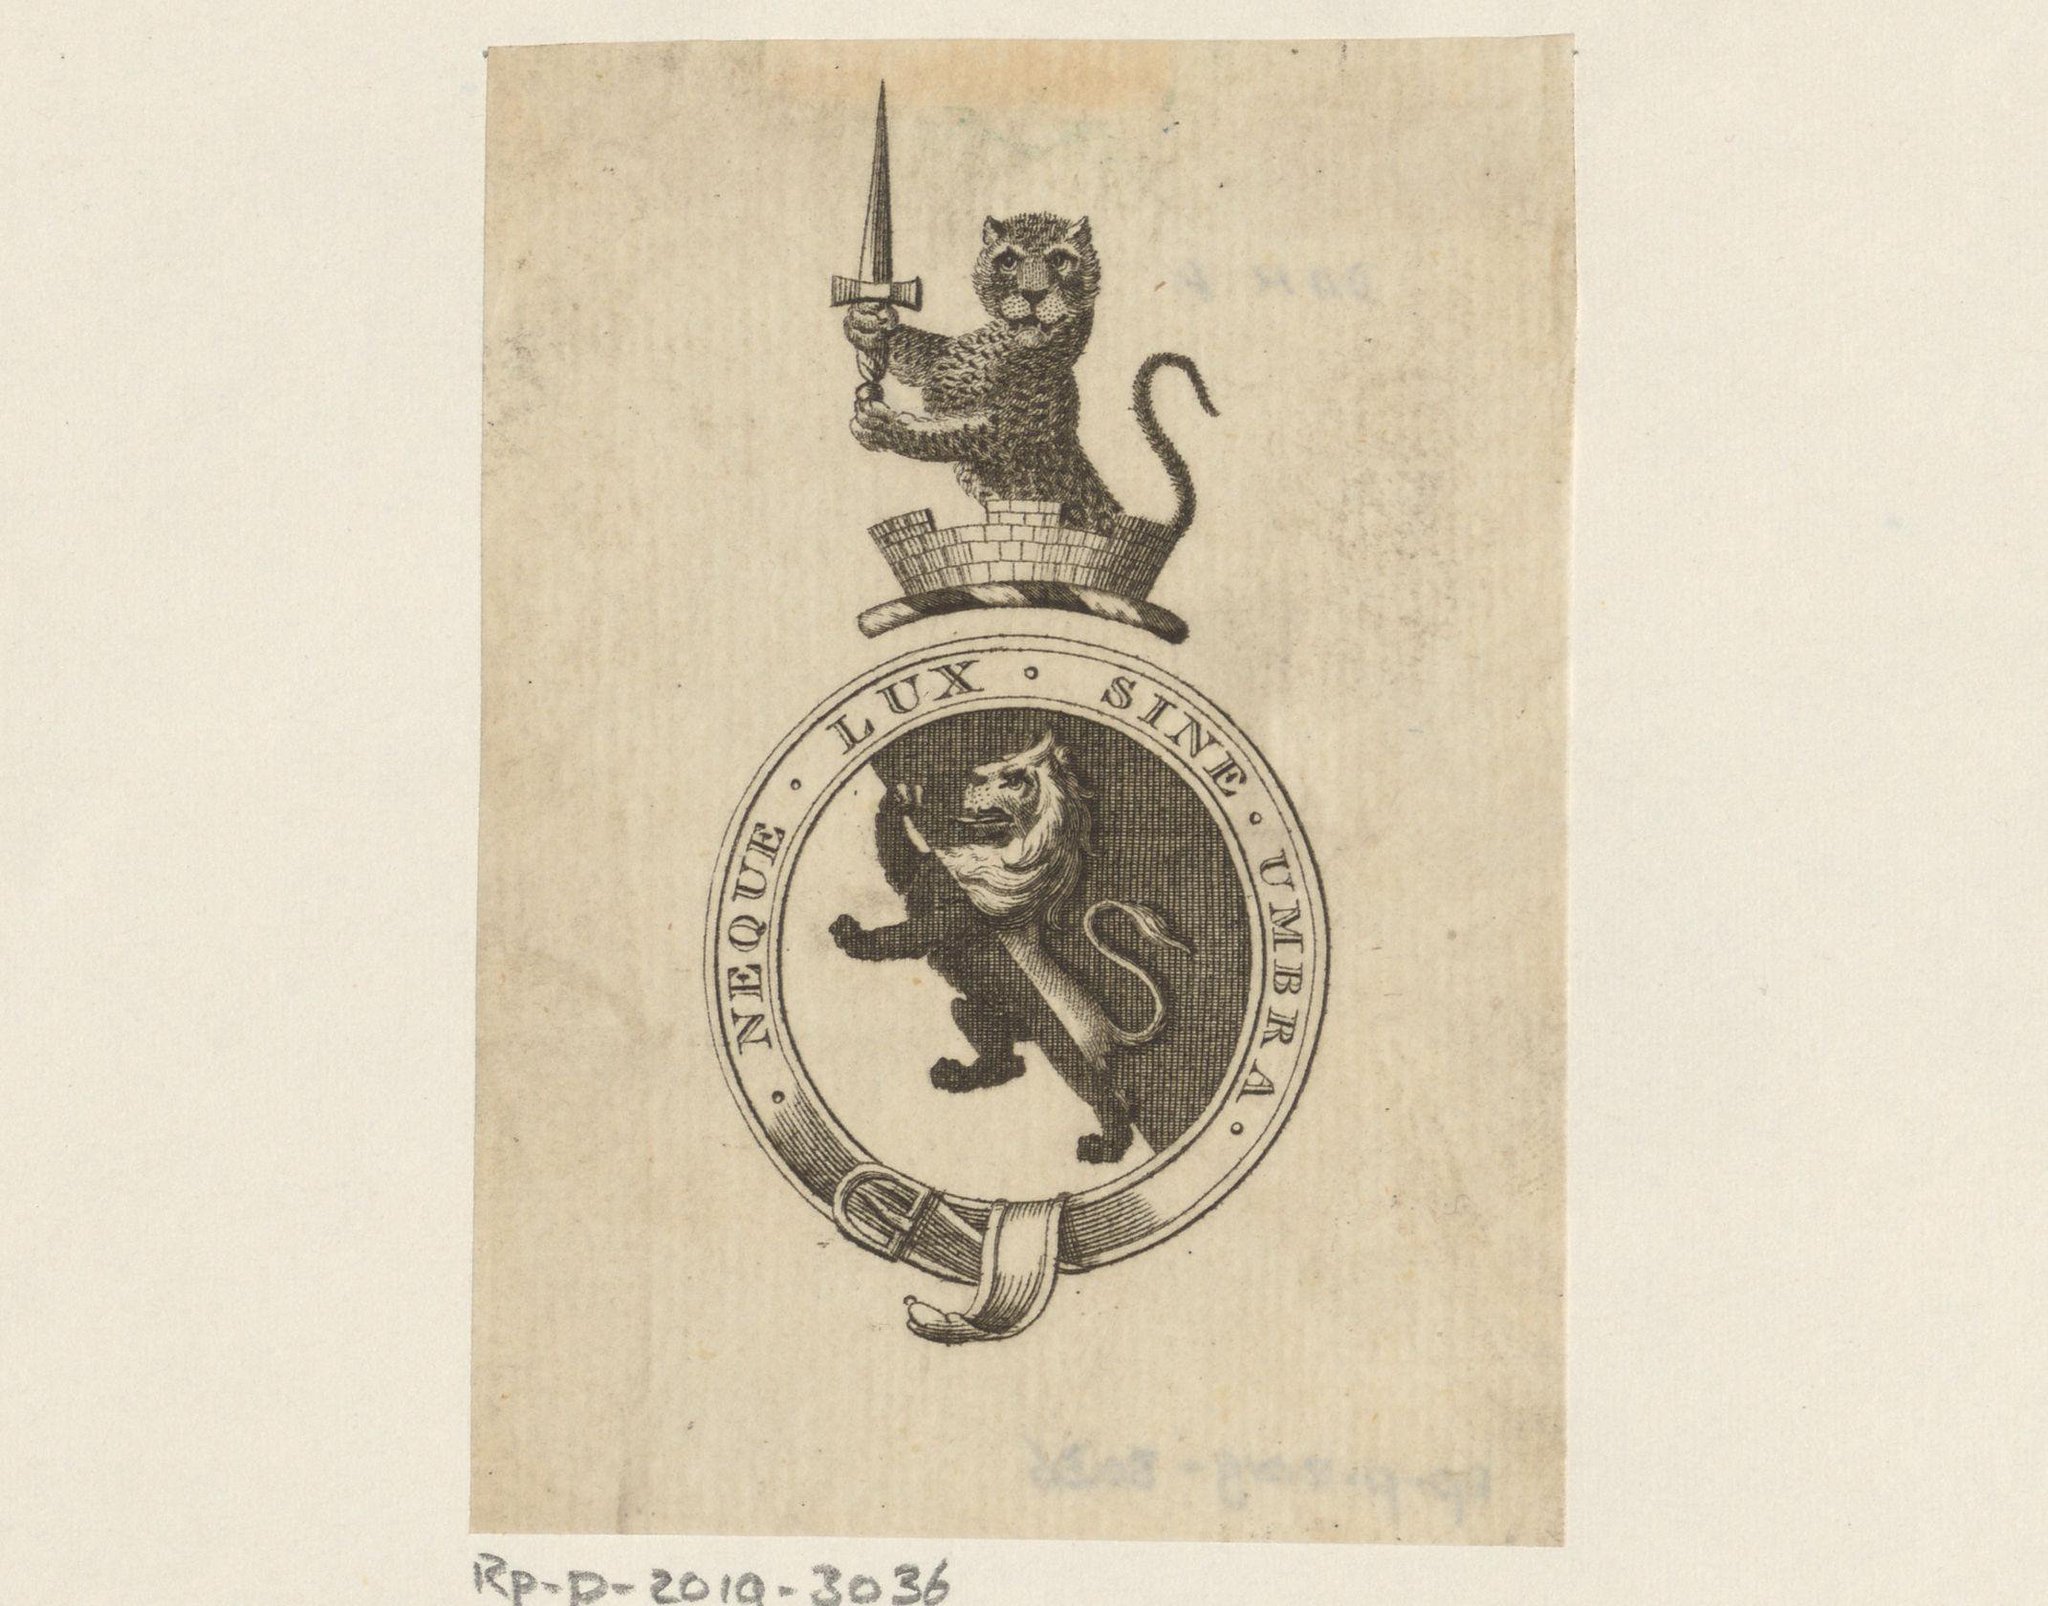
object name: bookplate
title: Neque lux sine umbra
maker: Anonymous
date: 1750-1849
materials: paper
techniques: engraving, etching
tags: armorial bearing, heraldry